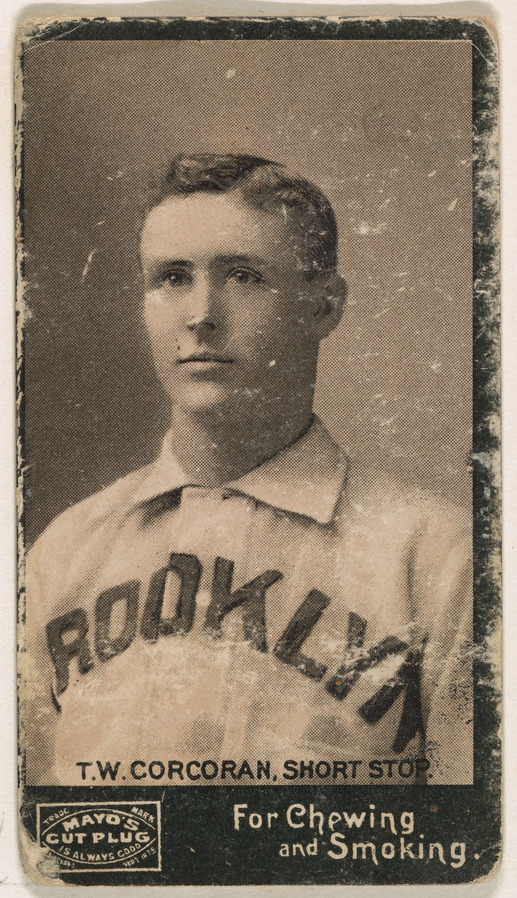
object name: print, baseball card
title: T. W. Corcoran, Shortstop, Brooklyn, from Mayo's Cut Plug Baseball series (N300)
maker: p.h. mayo & brother, richmond, virginia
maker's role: publisher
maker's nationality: american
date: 1895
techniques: lithography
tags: men,portraits,baseball,athletes